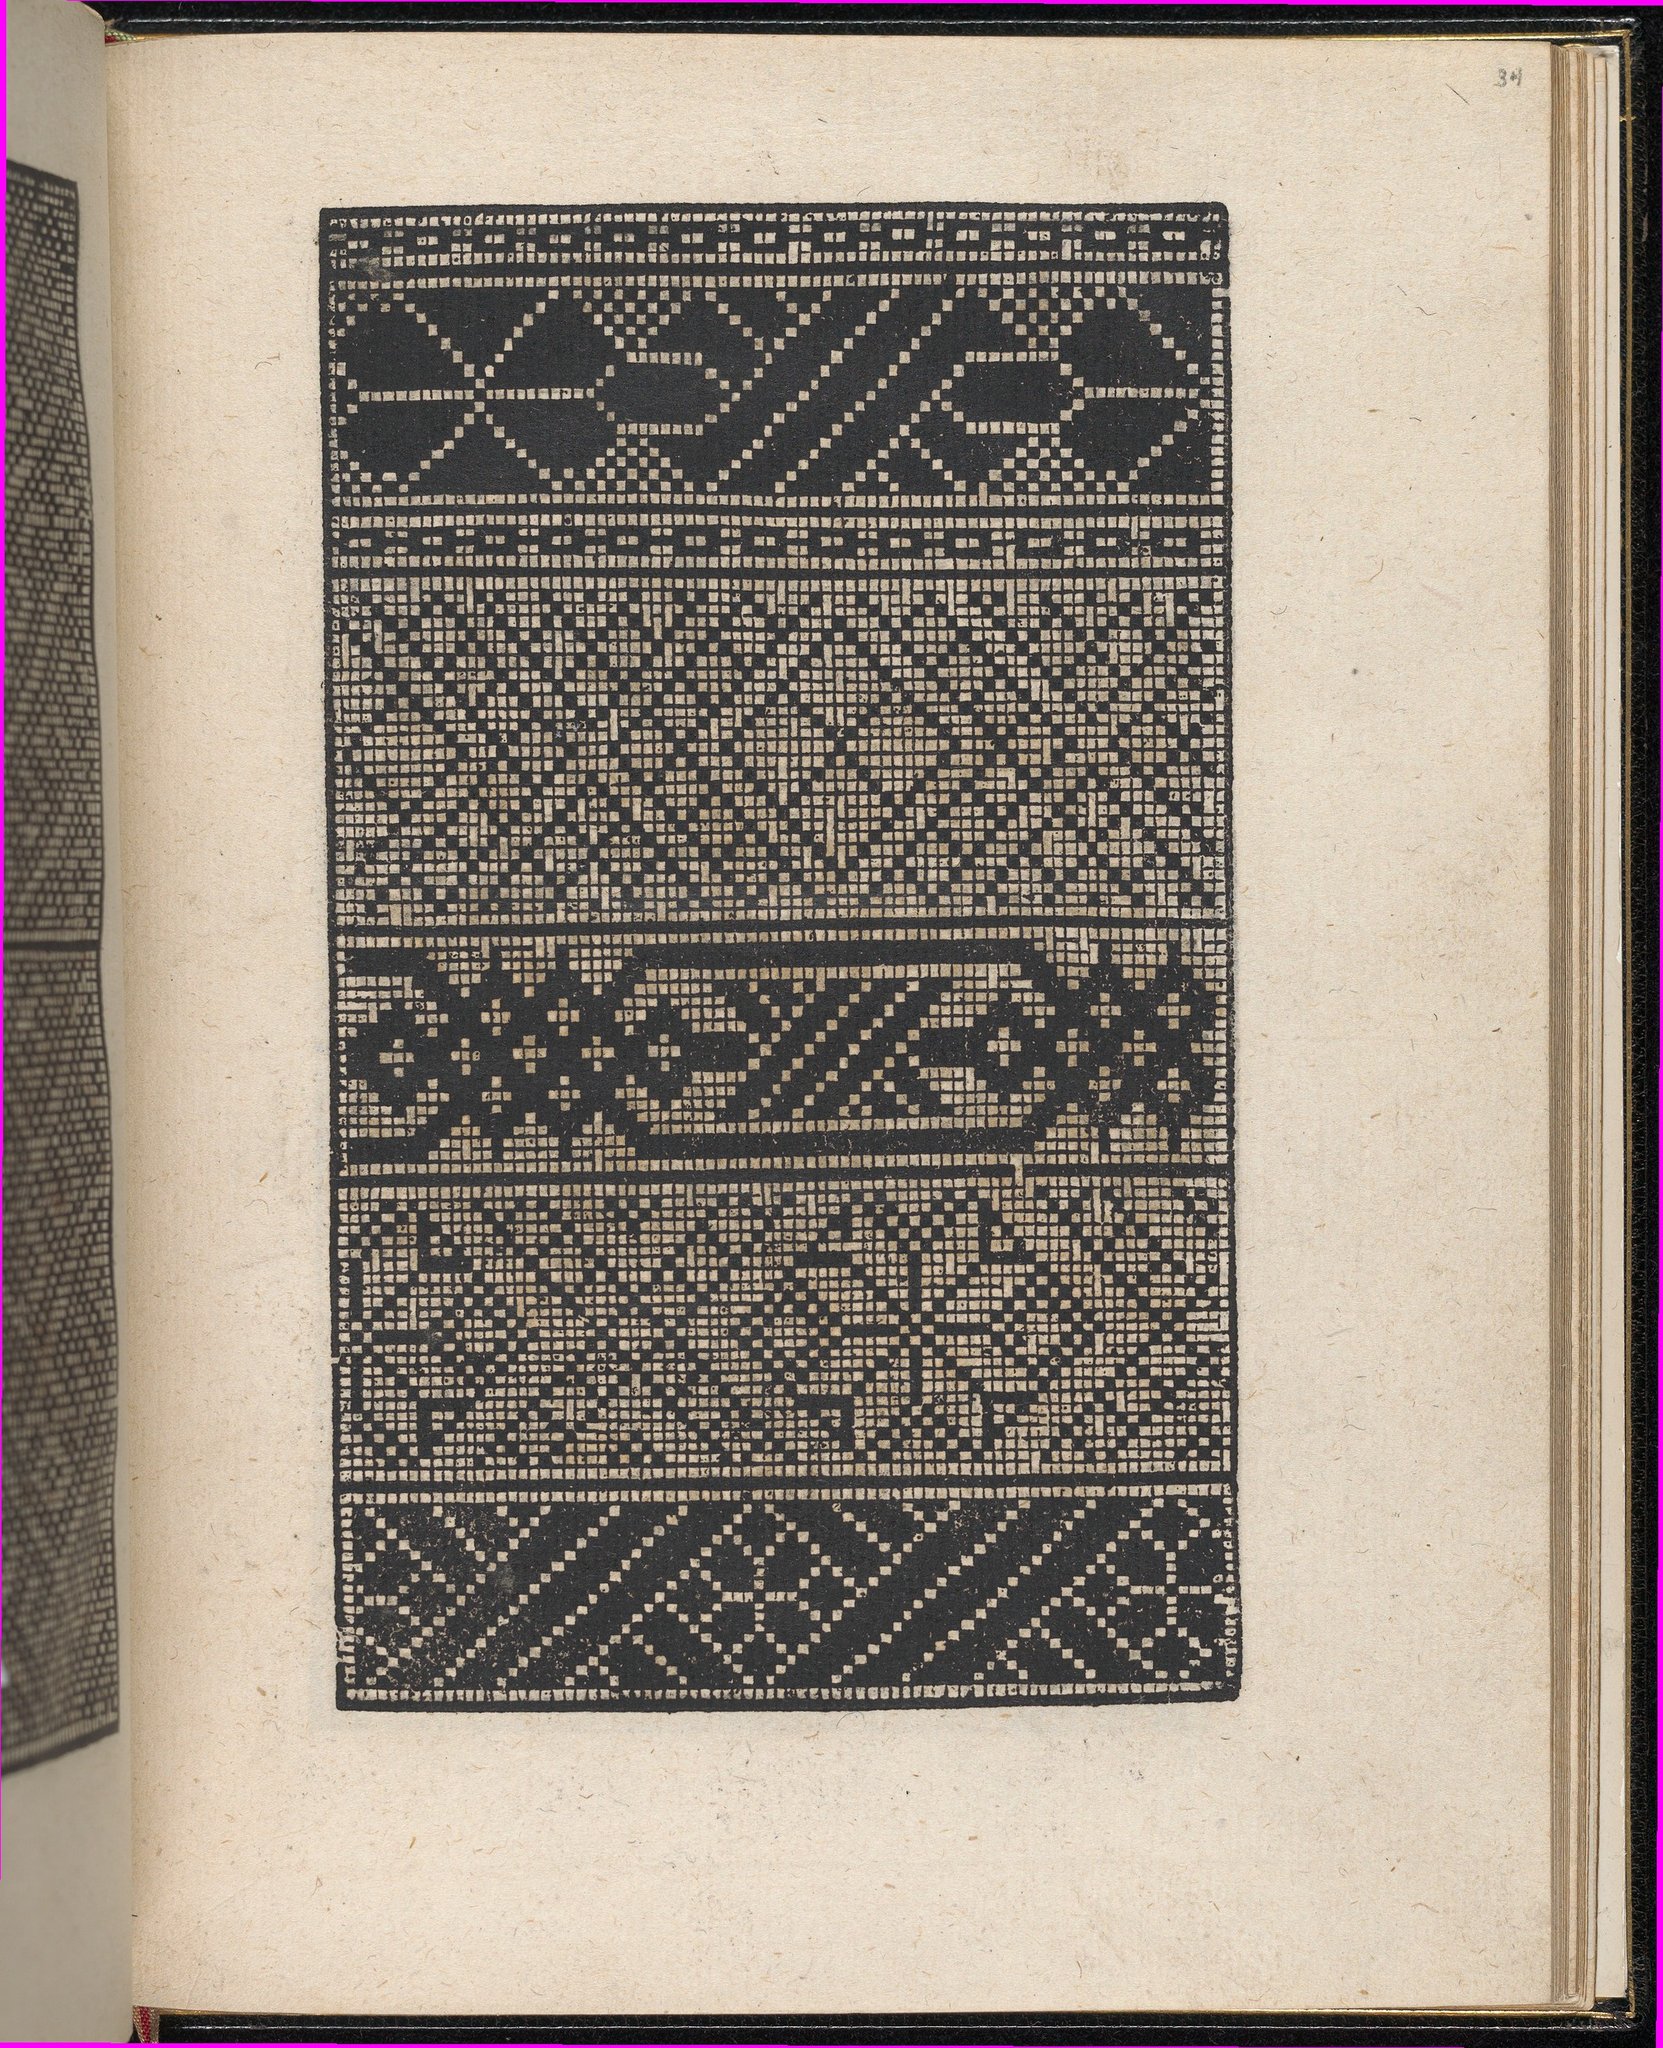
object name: book print ornament architecture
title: Page from Ein new kunstlich Modelbuch...(Page 34r)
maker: peter quentel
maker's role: publisher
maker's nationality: german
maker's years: 1500-1550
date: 1544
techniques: woodcut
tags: ornament